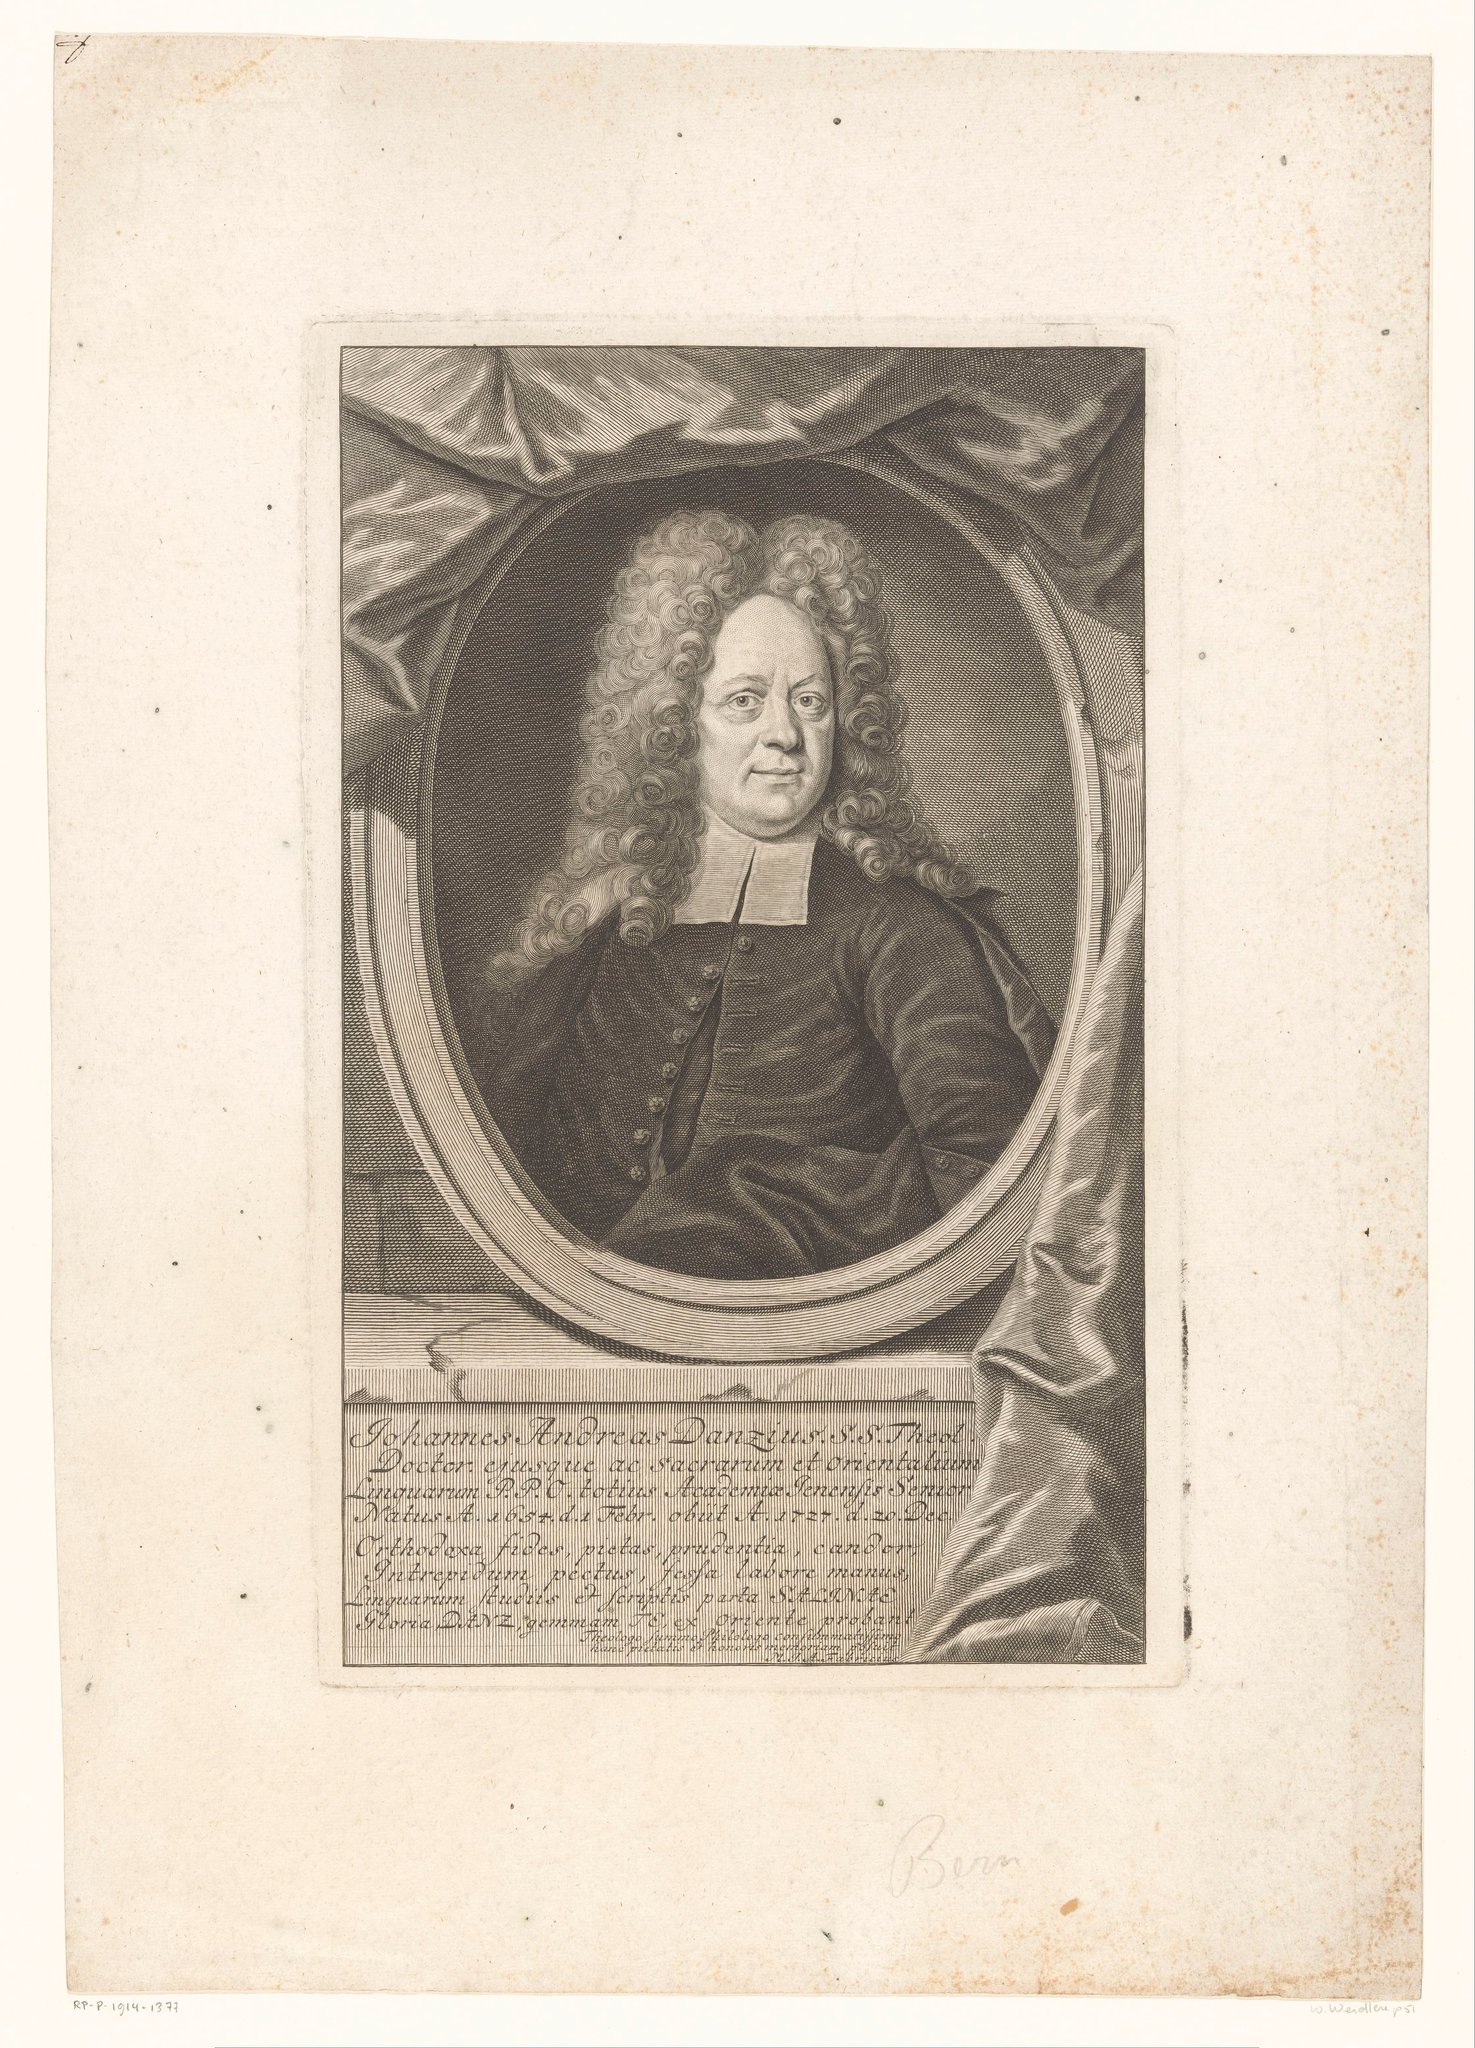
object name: print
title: Portret van Johann Andreas Danz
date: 1727-1733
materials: paper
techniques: engraving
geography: hamburg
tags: historical persons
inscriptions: collector's mark: Lugt 2228